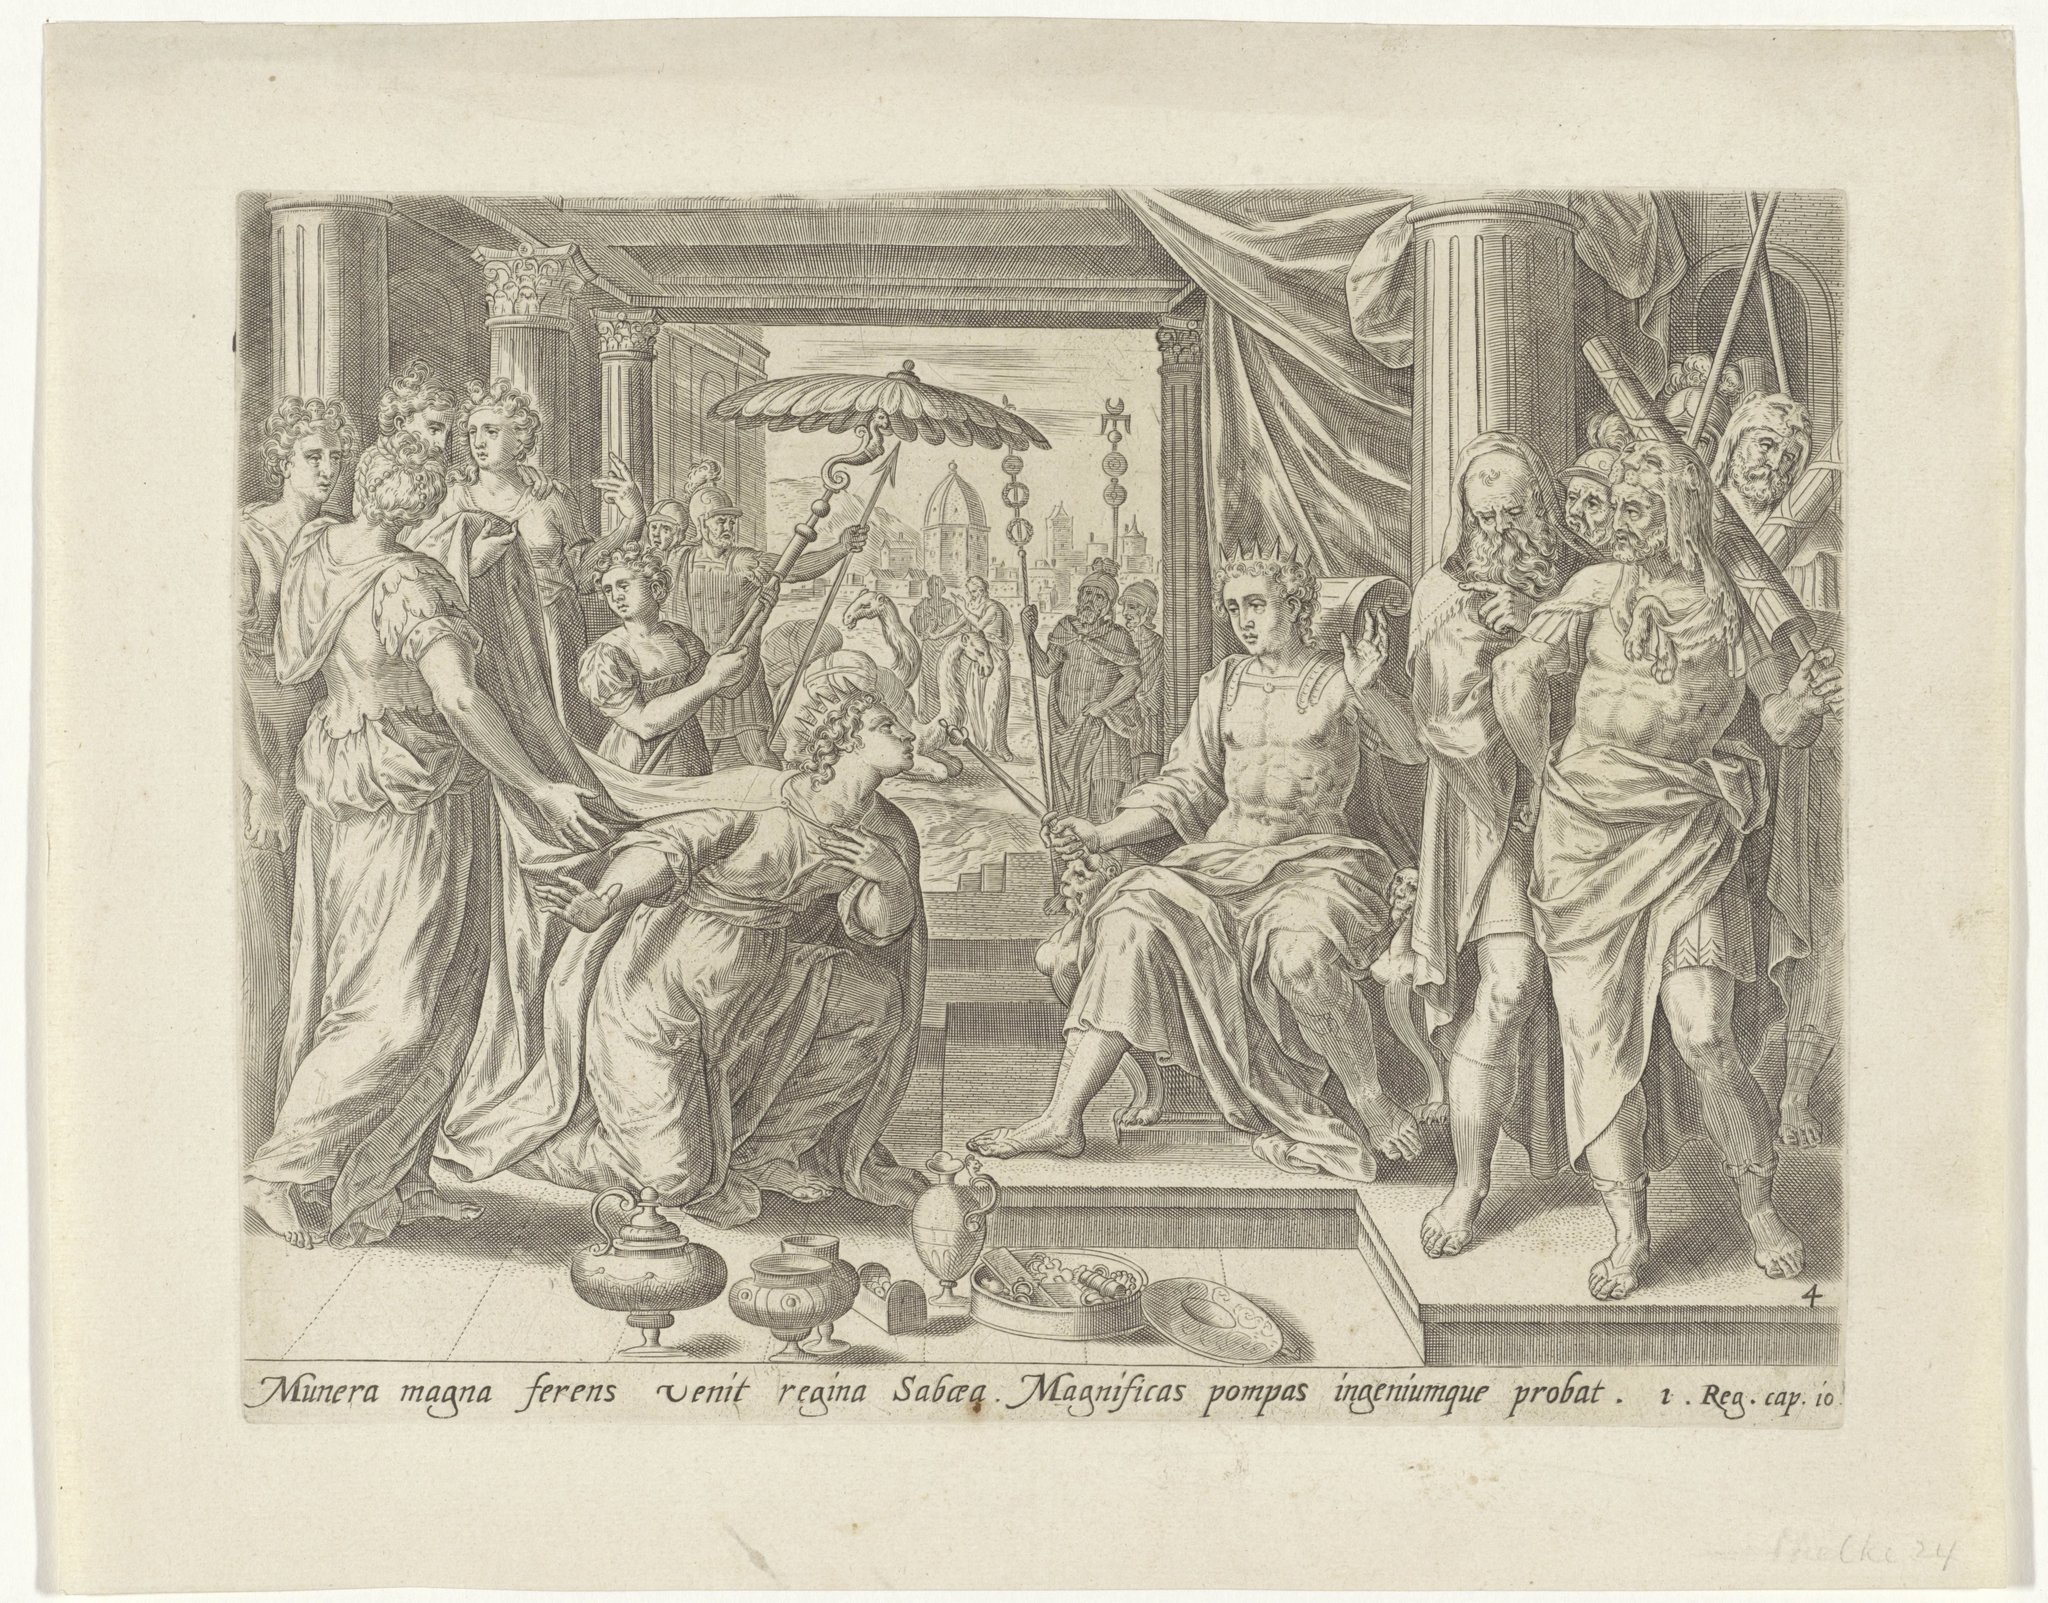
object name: print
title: Salomo ontvangt de koningin van Seba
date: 1579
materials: paper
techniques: engraving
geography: amsterdam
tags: solomon and the queen of sheba (1 kings 10:1-3; 2 chronicles 9:1-9)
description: Prent gebruikt in: Theatrum biblicum : hoc est historiae sacrae veteris et novi testamenti tabulis aeneis expressae. Opus praesentatissimorum huius ac superioris seculi pictorum atque sculptorum, summo studio conquisitum et in lucem editum. Amsterdam: Claes Jansz. Visscher, 1643.